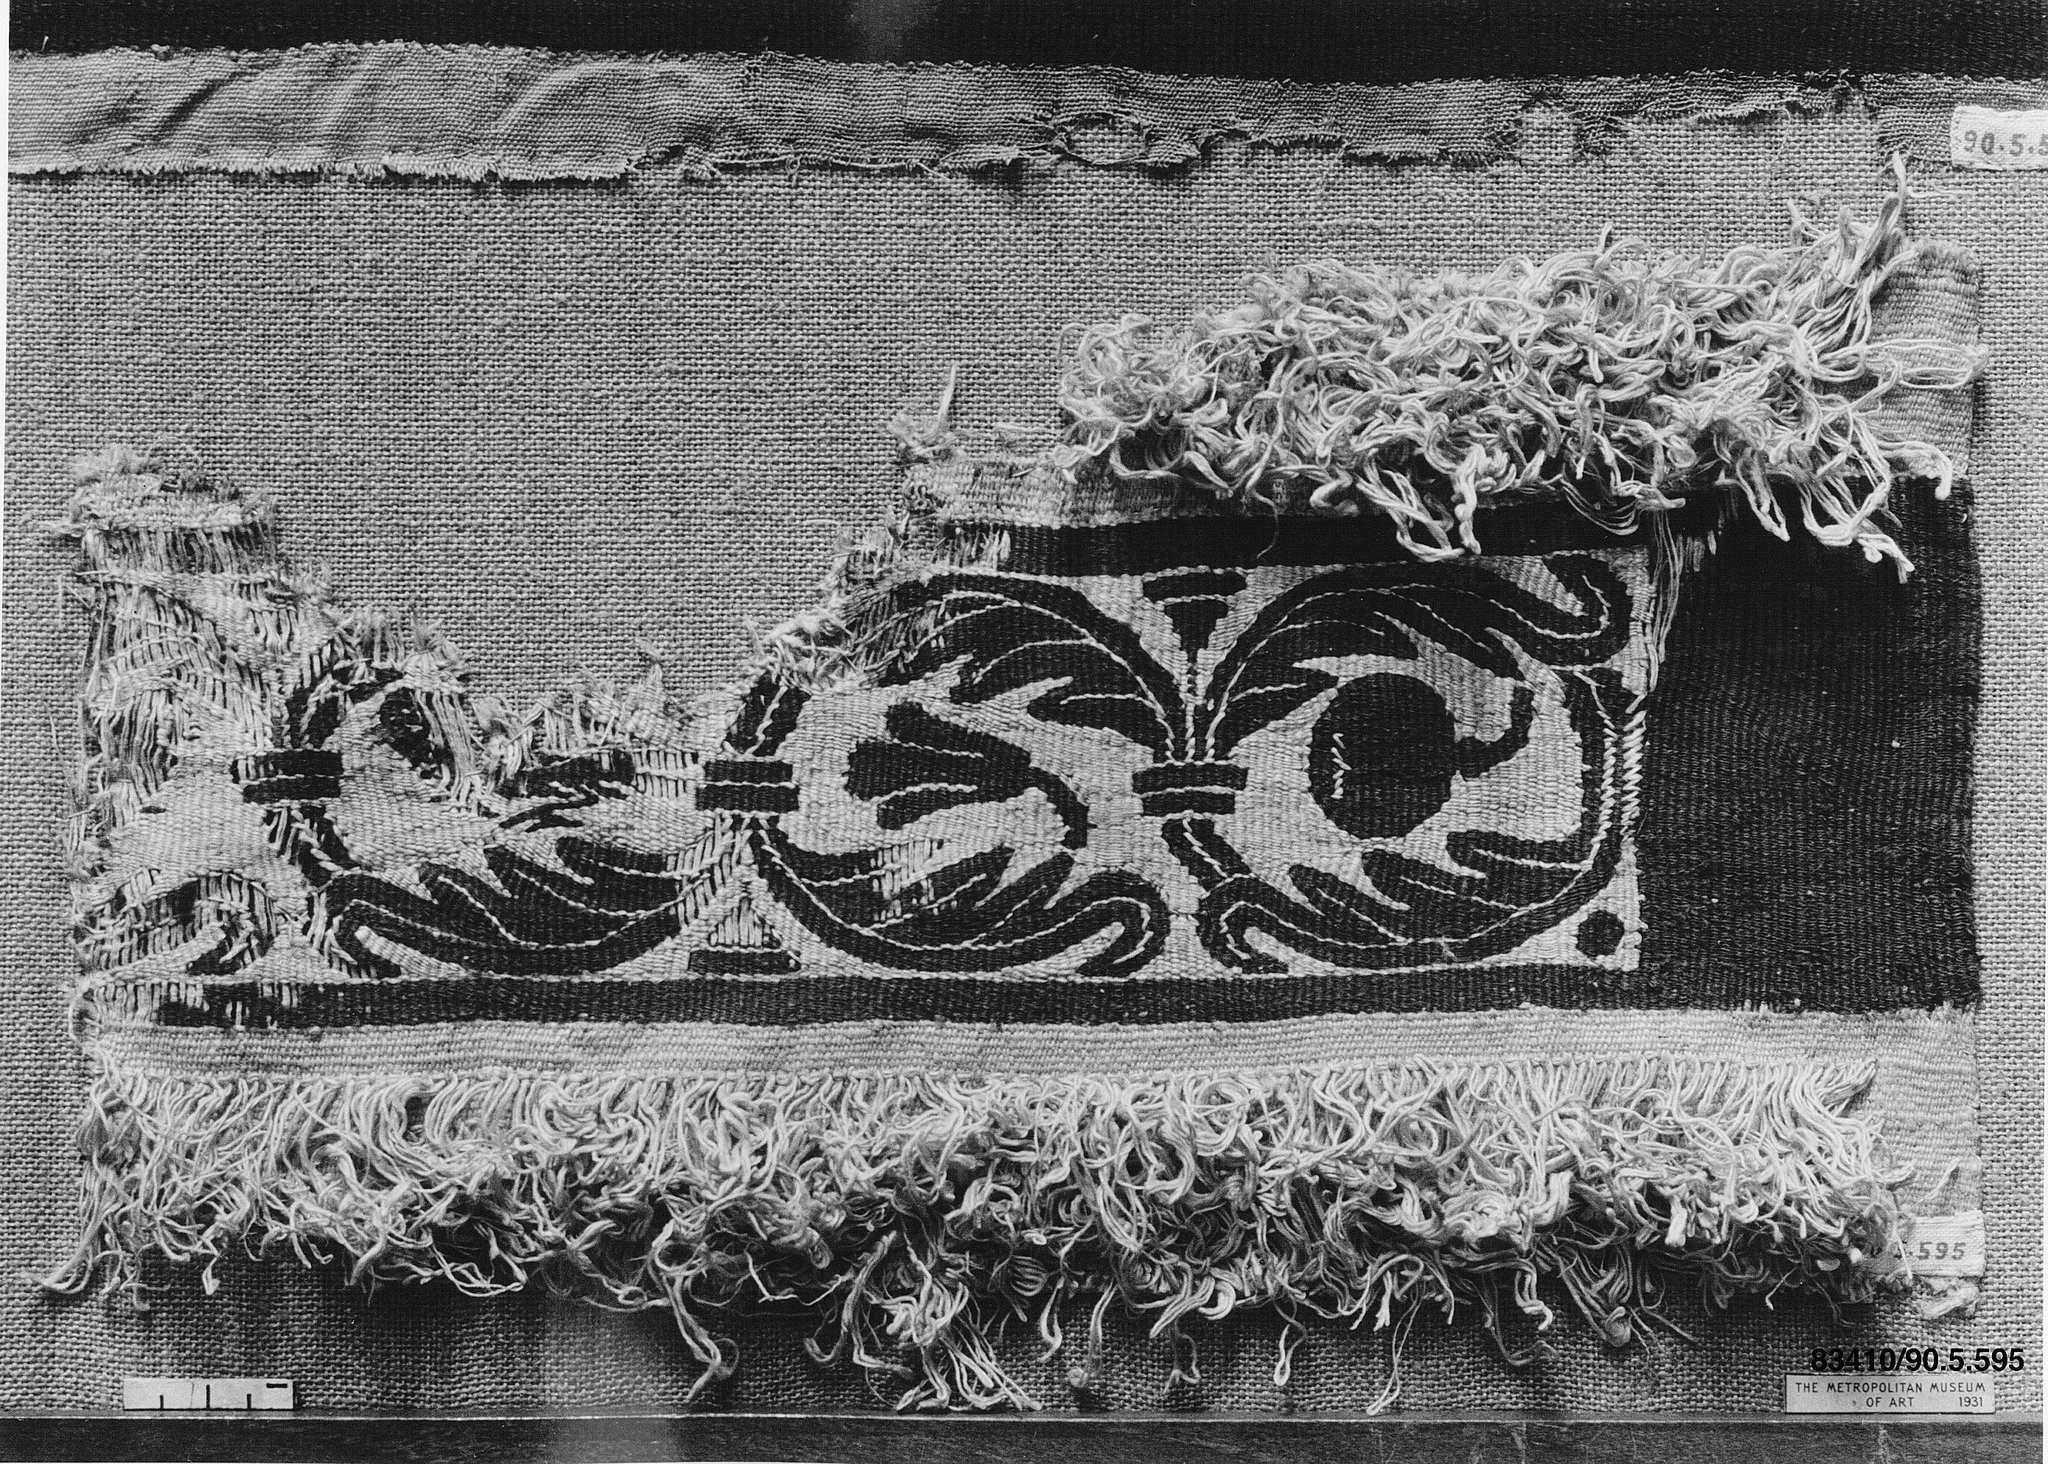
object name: textile fragment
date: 201-400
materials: linen, wool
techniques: weave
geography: egypt